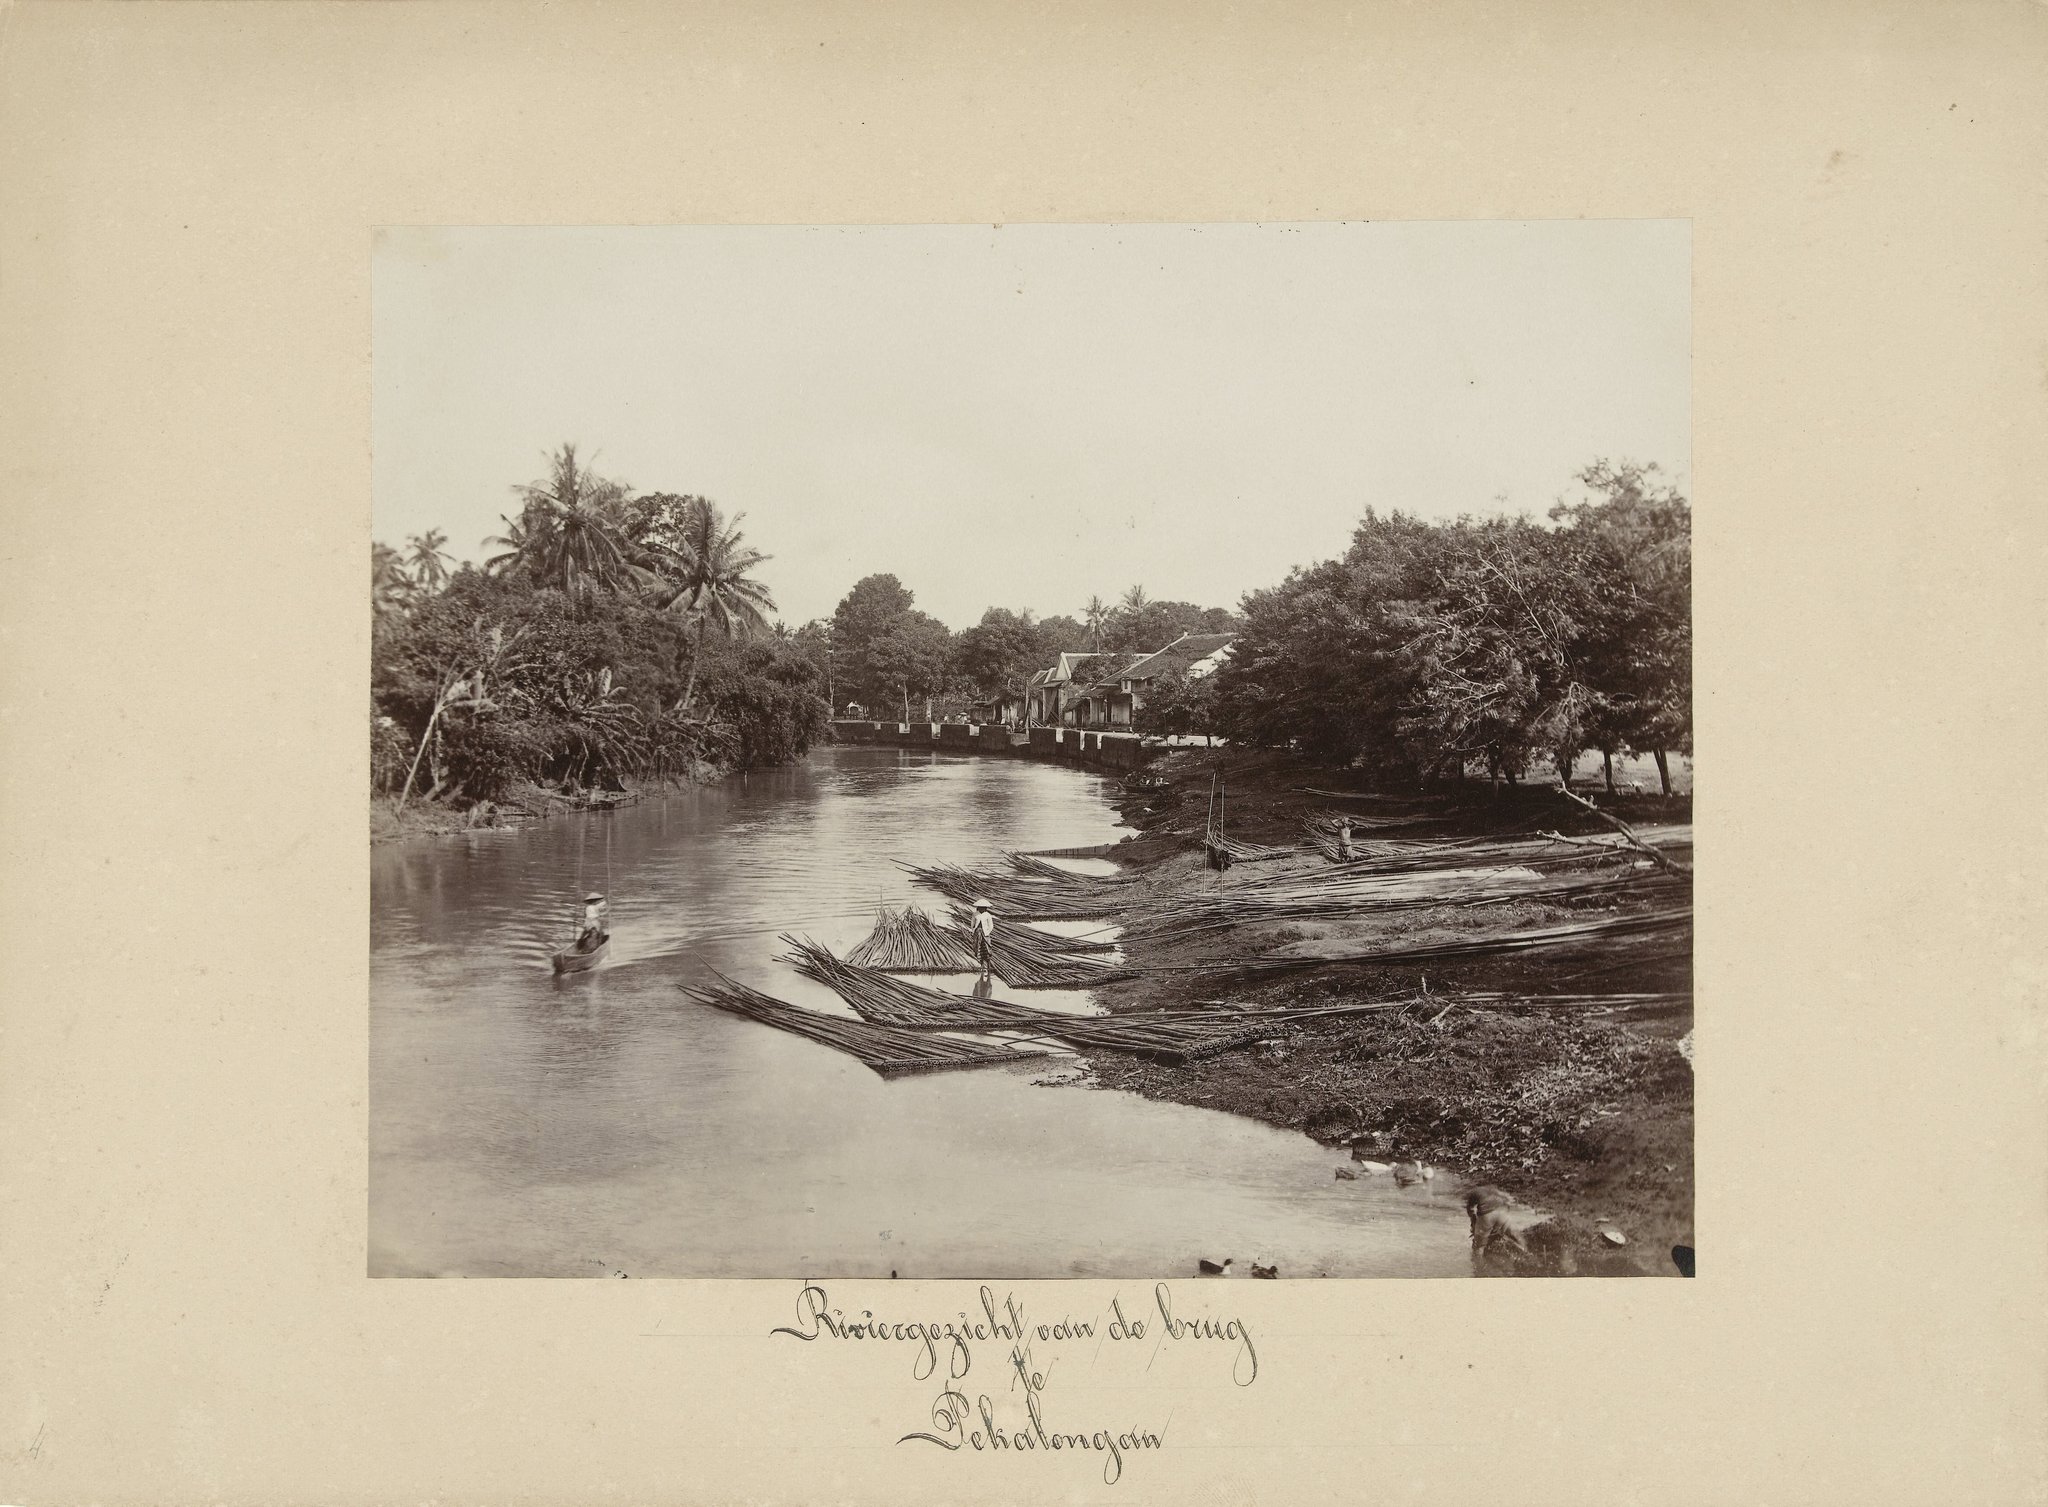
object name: photograph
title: Houtverwerking op de rivier te Pekalongan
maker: Anonymous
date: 1850-1880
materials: cardboard, paper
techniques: albumen print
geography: pekalongan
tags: timber floating down the river, river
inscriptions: inscription: ‘Riviergezicht van de brug/ te/ Pekalongan’